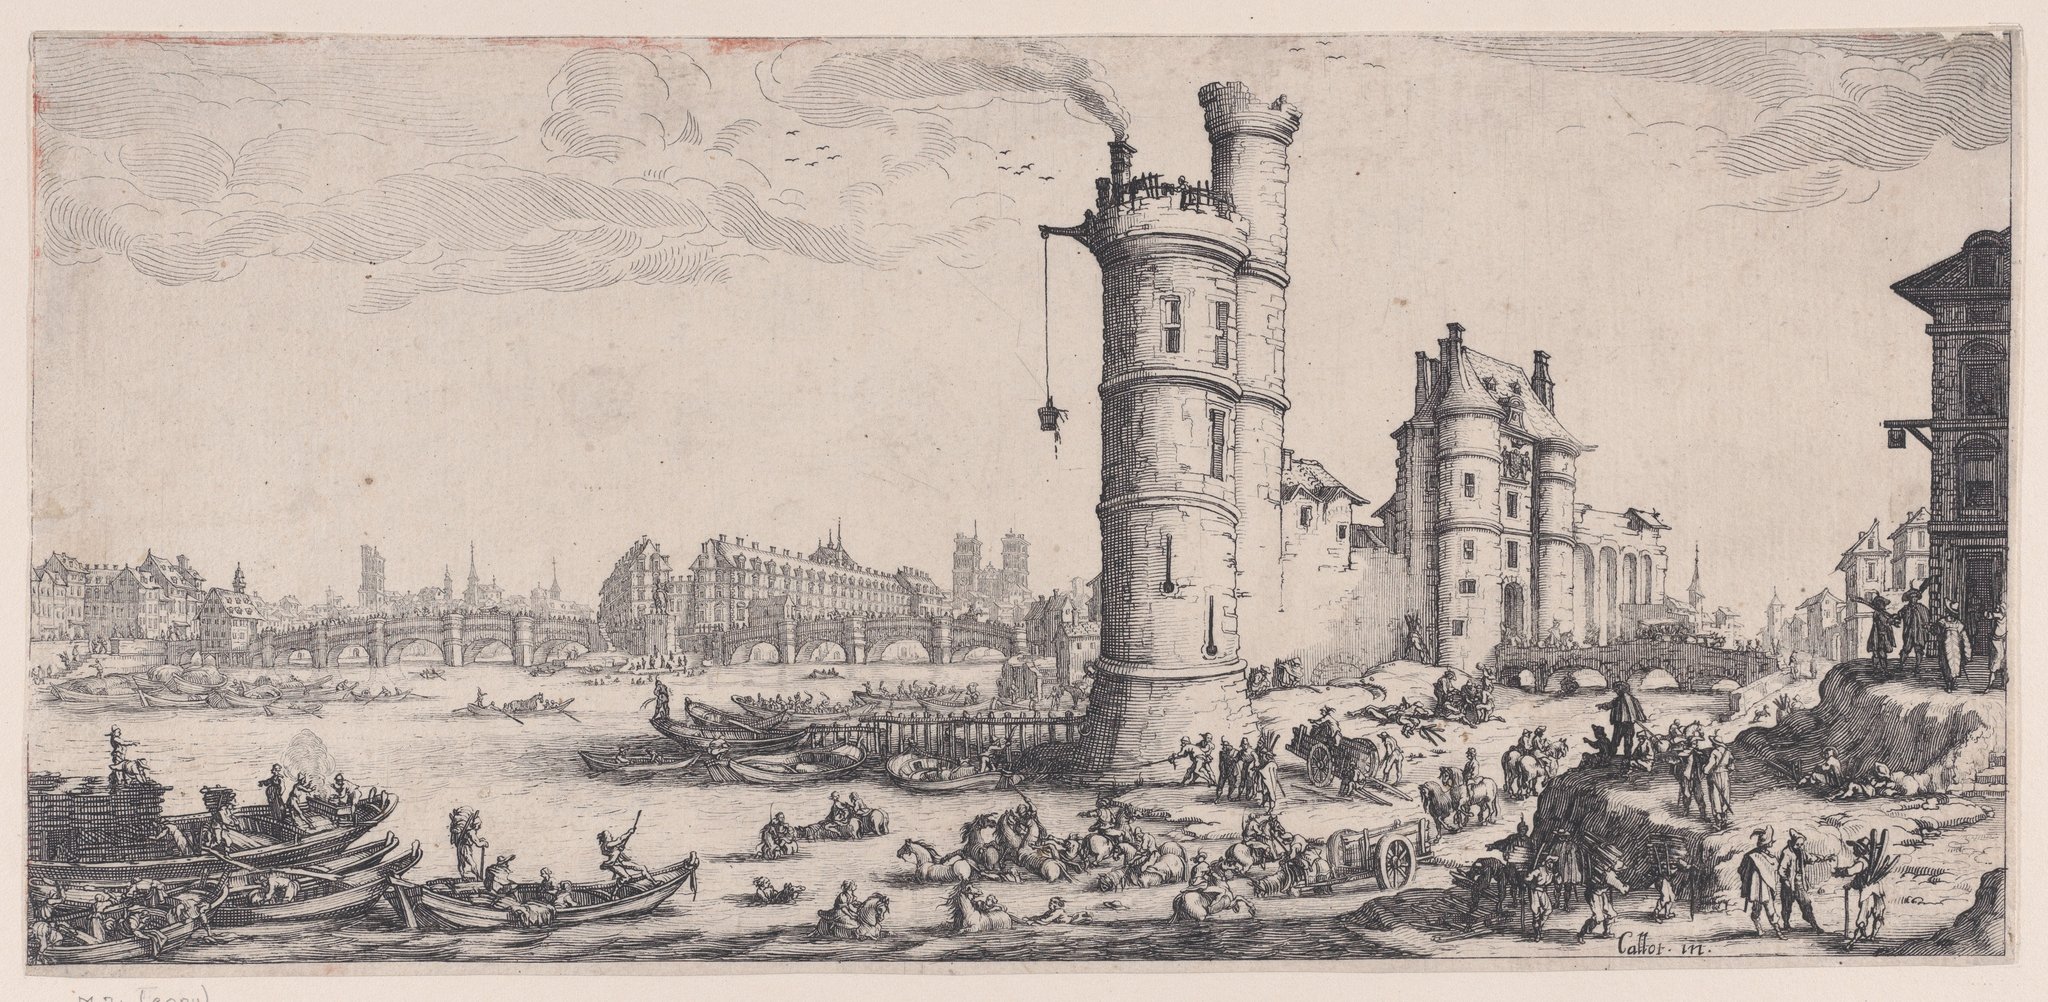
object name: print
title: Copy of Vue de Pont-Neuf (View of the Pont Neuf), from "Les Deux Grandes Vues de Paris" (The Two Large Views of Paris)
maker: Anonymous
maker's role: artist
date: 1601-1700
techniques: etching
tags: towers,cities,rivers,boats,paris